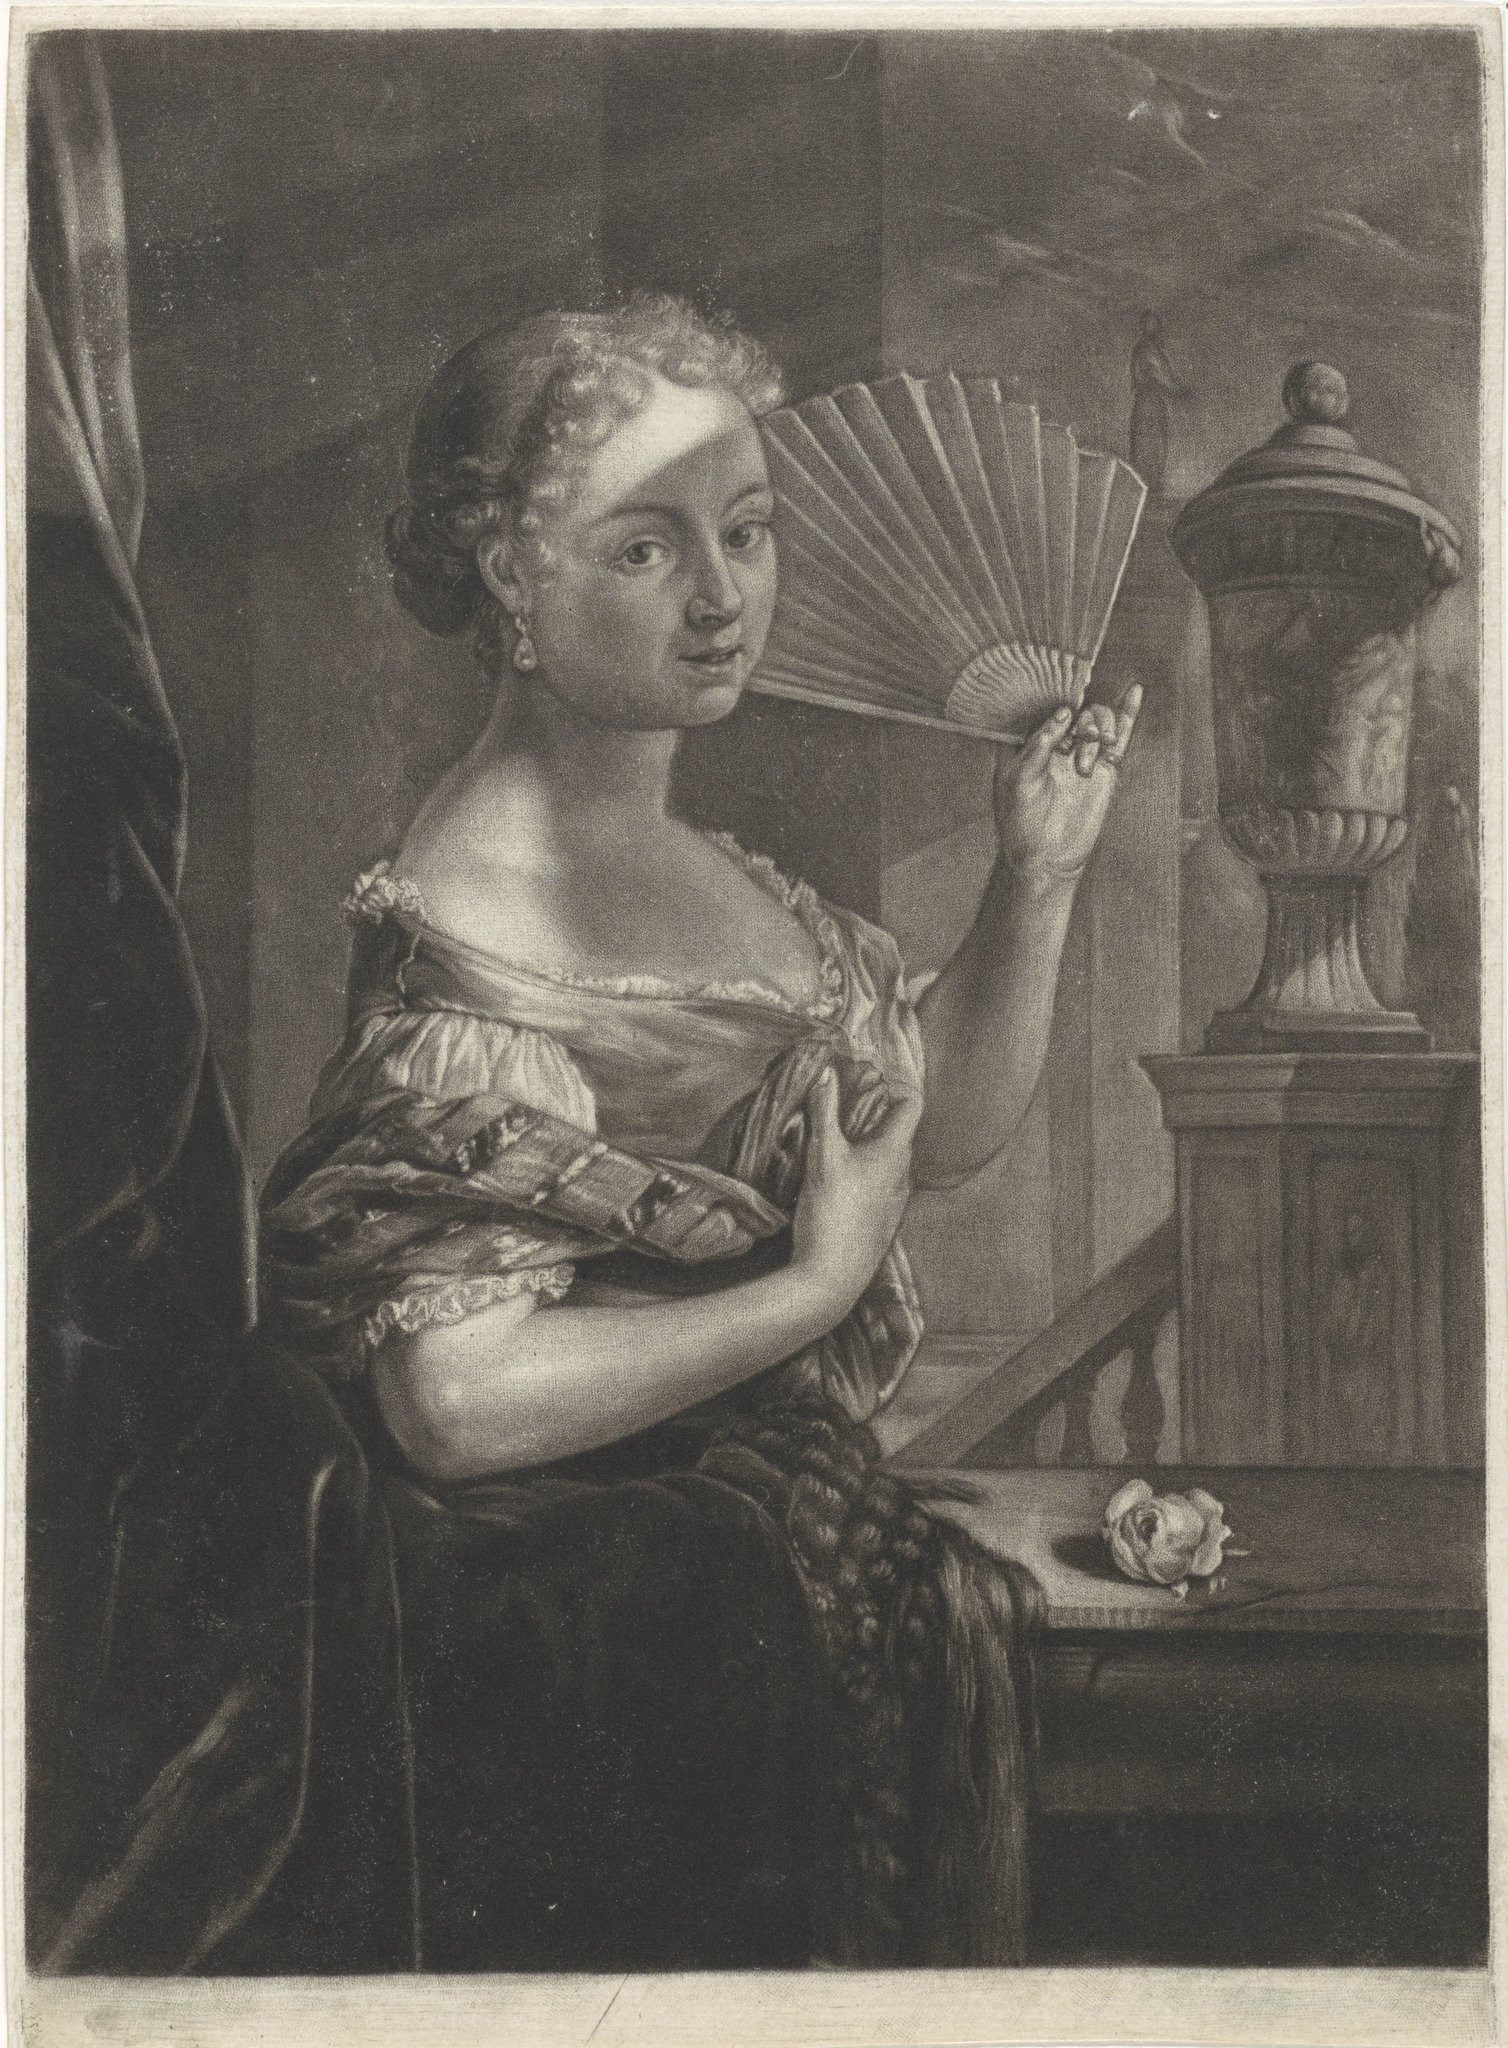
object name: print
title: Jonge vrouw met waaier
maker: jacob gole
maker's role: print maker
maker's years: 1660-1724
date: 1670-1724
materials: paper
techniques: mezzotint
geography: amsterdam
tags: fan, flowers: rose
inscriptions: collector's mark: Lugt 240